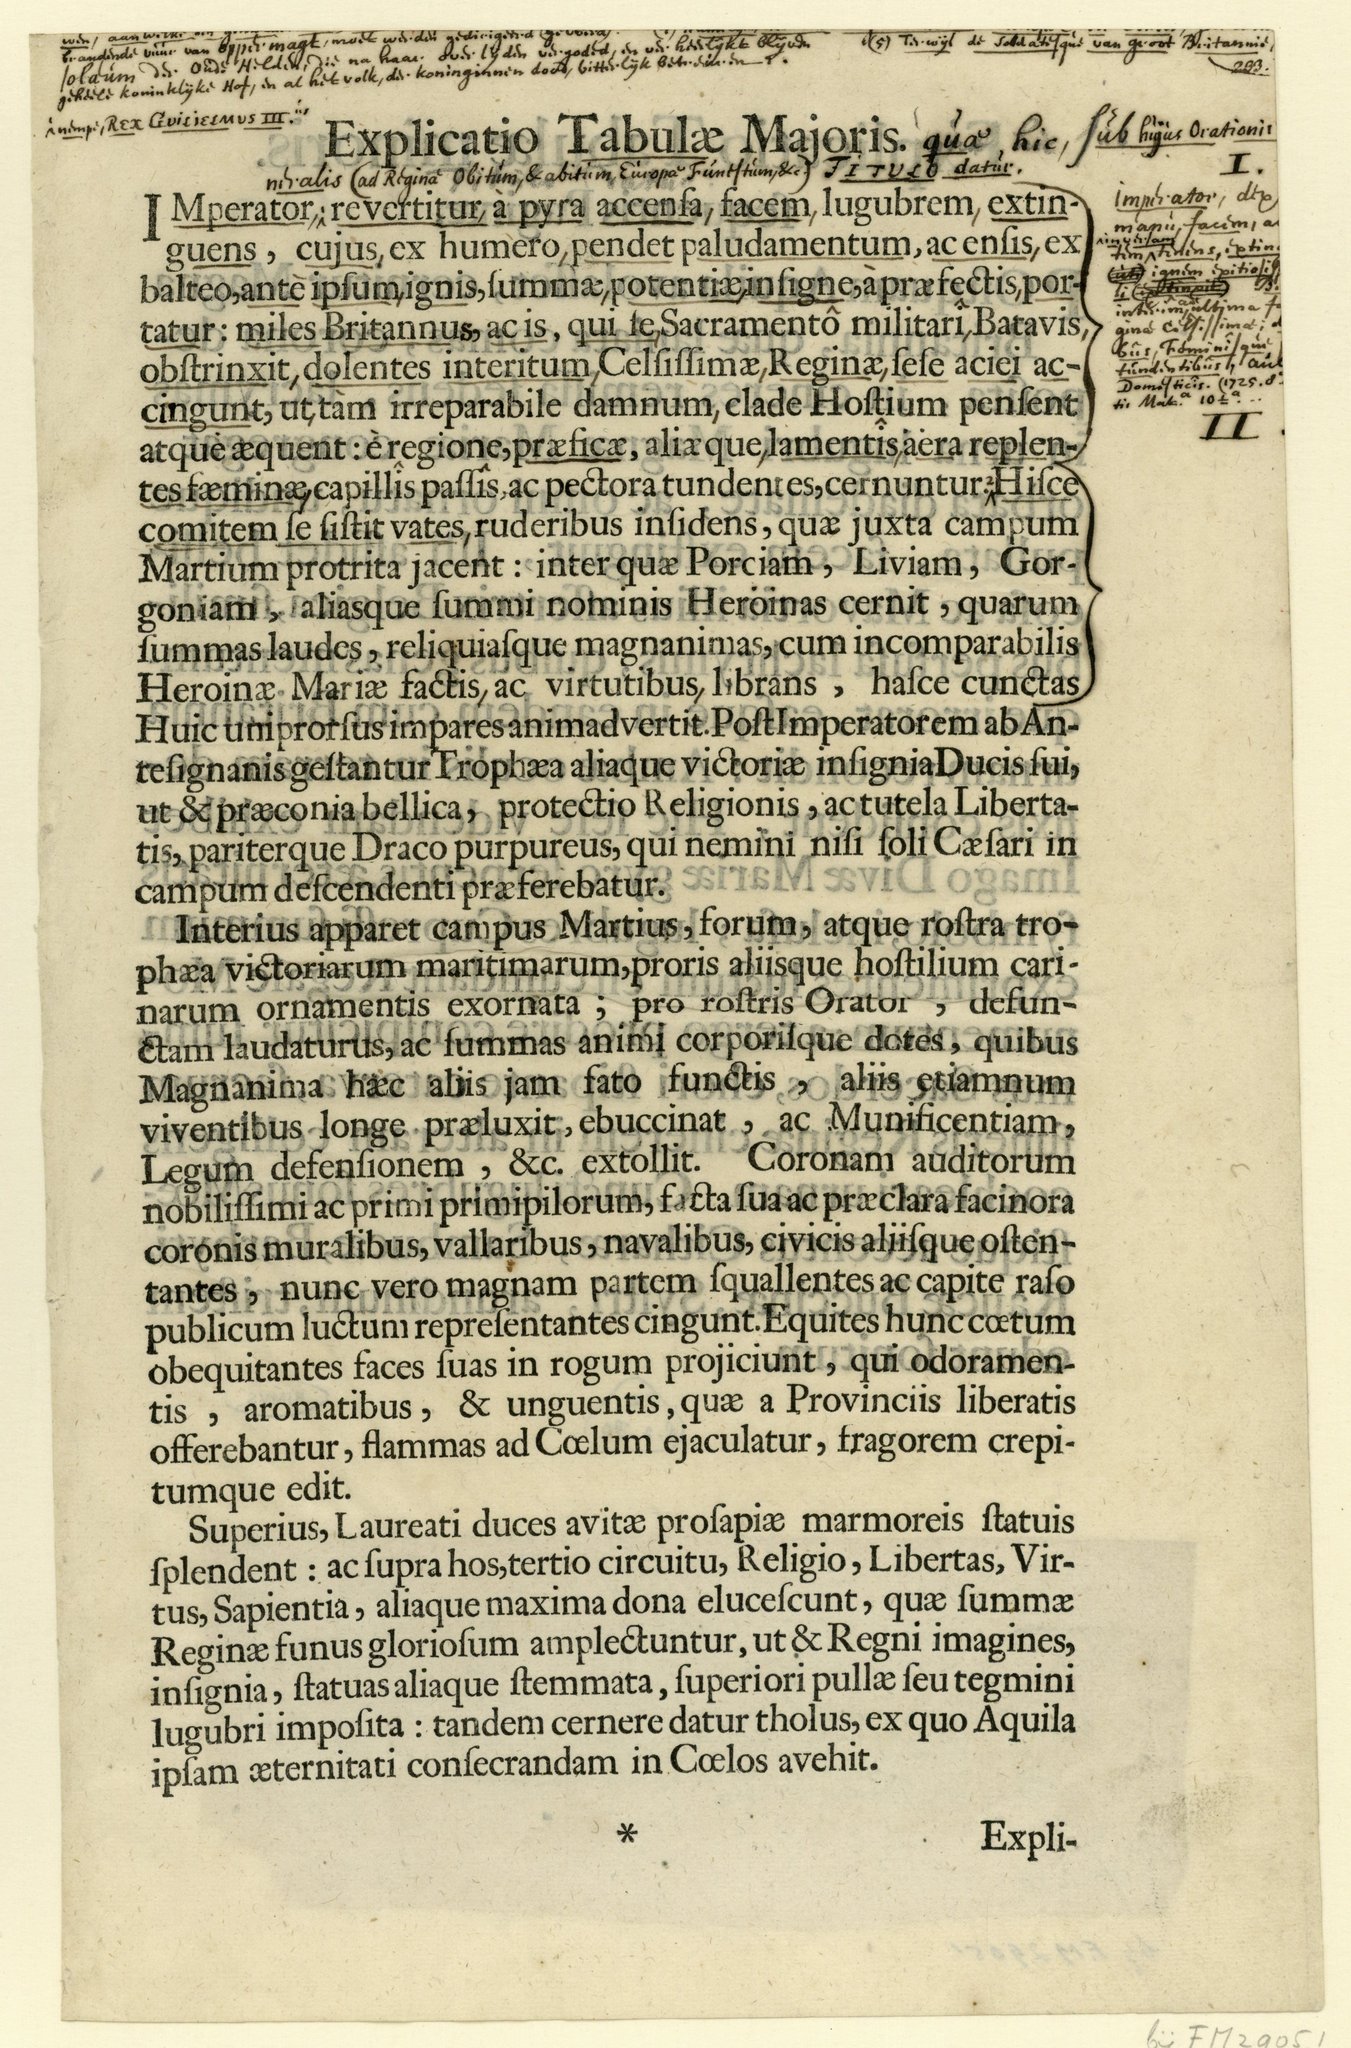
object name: print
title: Het overlijden en de lijkstatie van Maria II Stuart, koningin van Engeland, 1695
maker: samuel gruterus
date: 1695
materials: paper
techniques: letterpress printing, writing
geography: northern netherlands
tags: london, maria ii stuart (koningin van engeland, schotland en ierland)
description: Tekstblad behorend bij de titelpagina voor de prentserie over het overlijden en de lijkstatie van Maria II Stuart, koningin van Engeland, 1695. Verklaring van de voorstelling van de allegorische titelprent bij het boek van Samuel Gruterus: Funeralia Mariae II Britanniarum, Haarlem 1695. Latijnse tekst op voor- en achterzijde met verschillende onderstrepingen en notities in pen. Behoort bij de prent RP-P-OB-76.272.